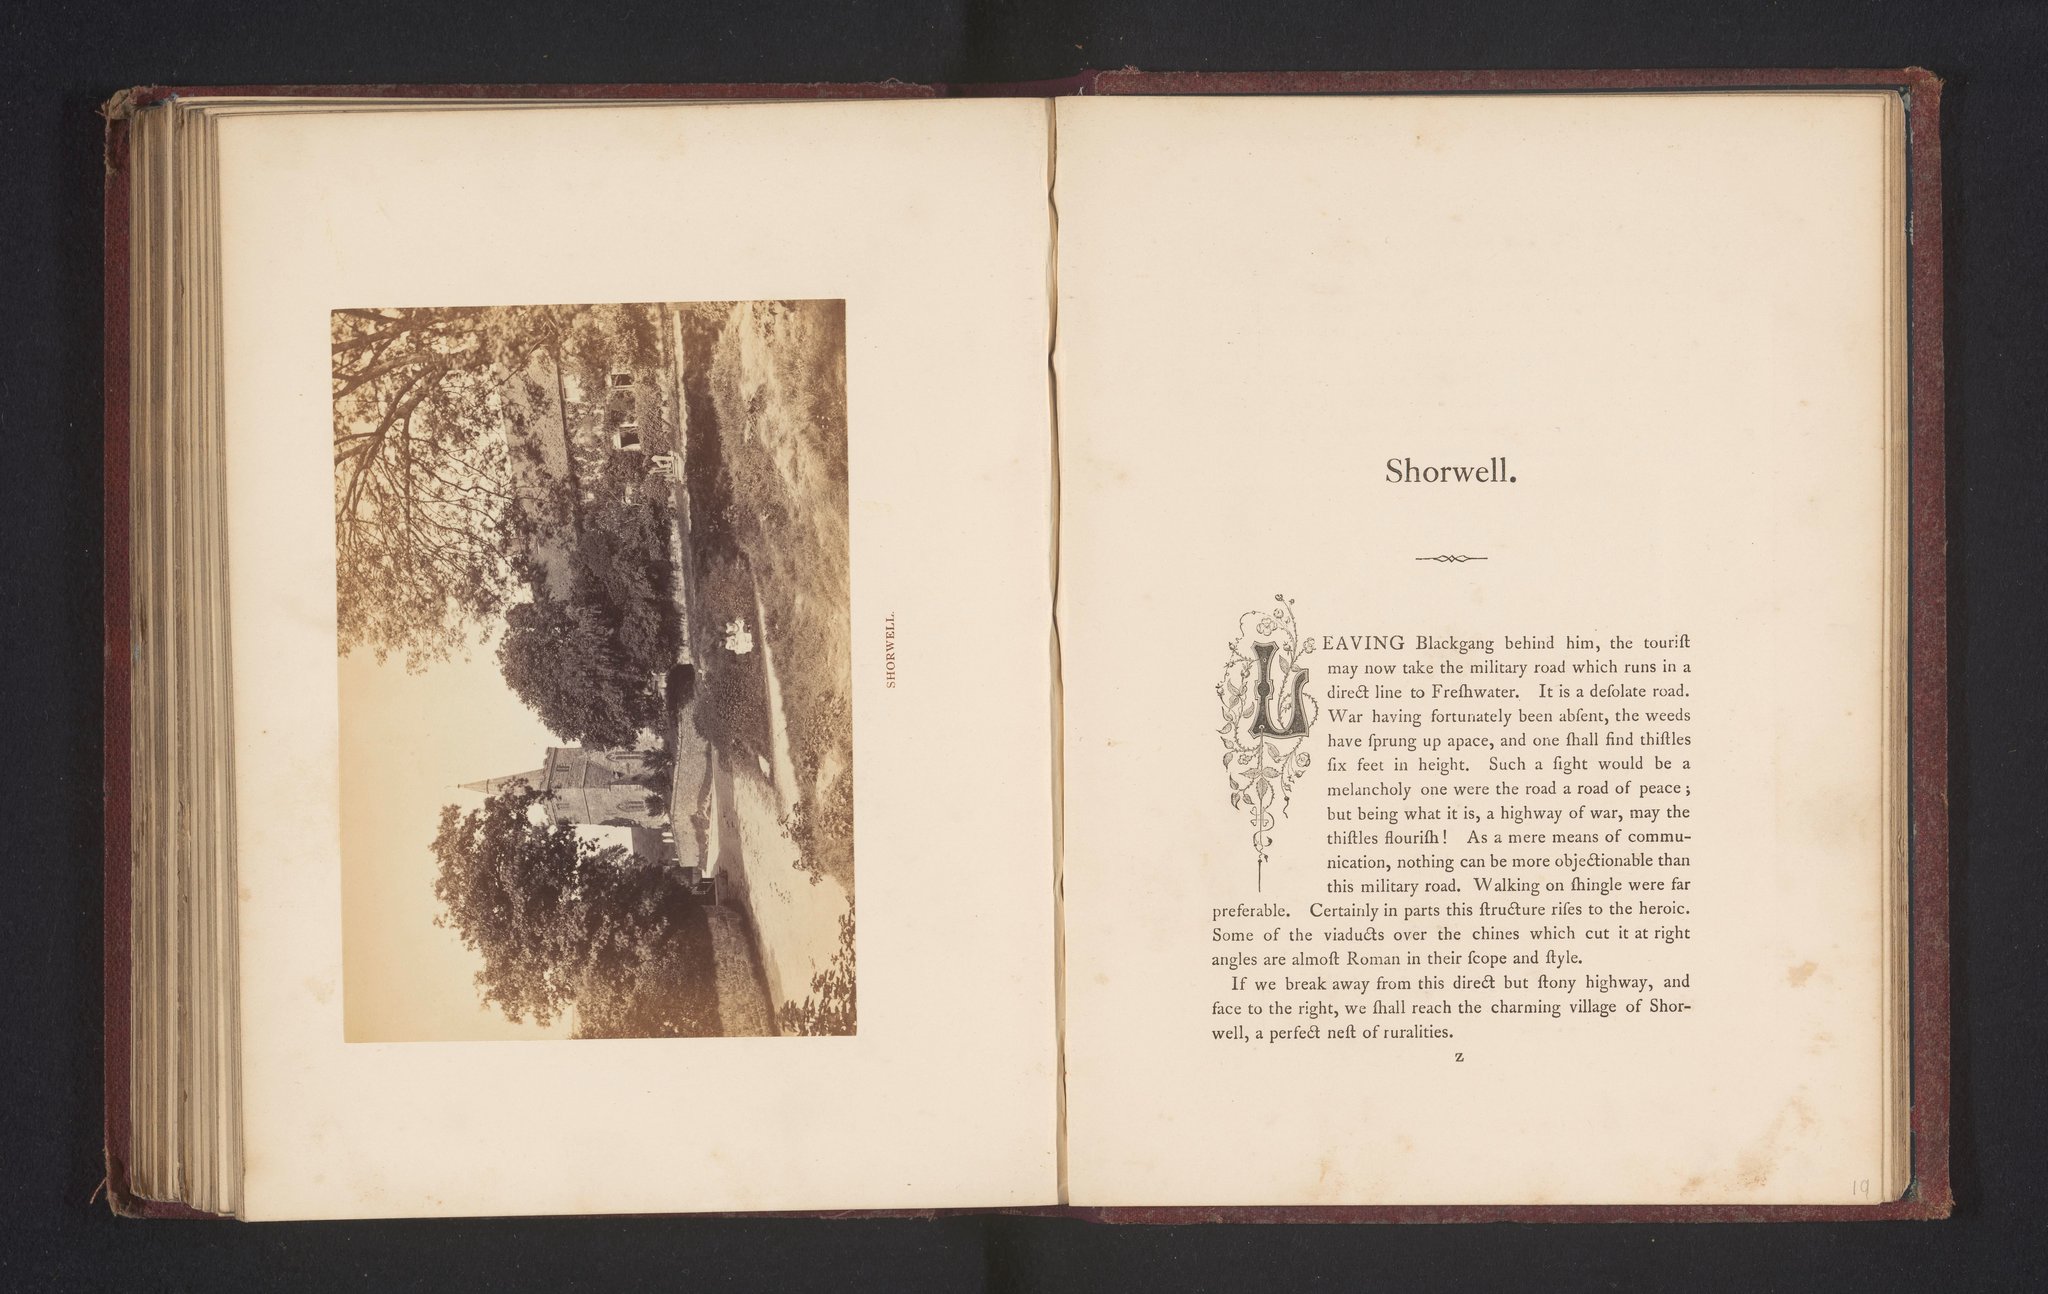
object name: photograph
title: Shorwell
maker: william russell sedgfield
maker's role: fotograaf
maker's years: 1826-1902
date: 1859-1869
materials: photographic support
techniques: albumen print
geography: shorwell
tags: church (exterior), public gardens, park